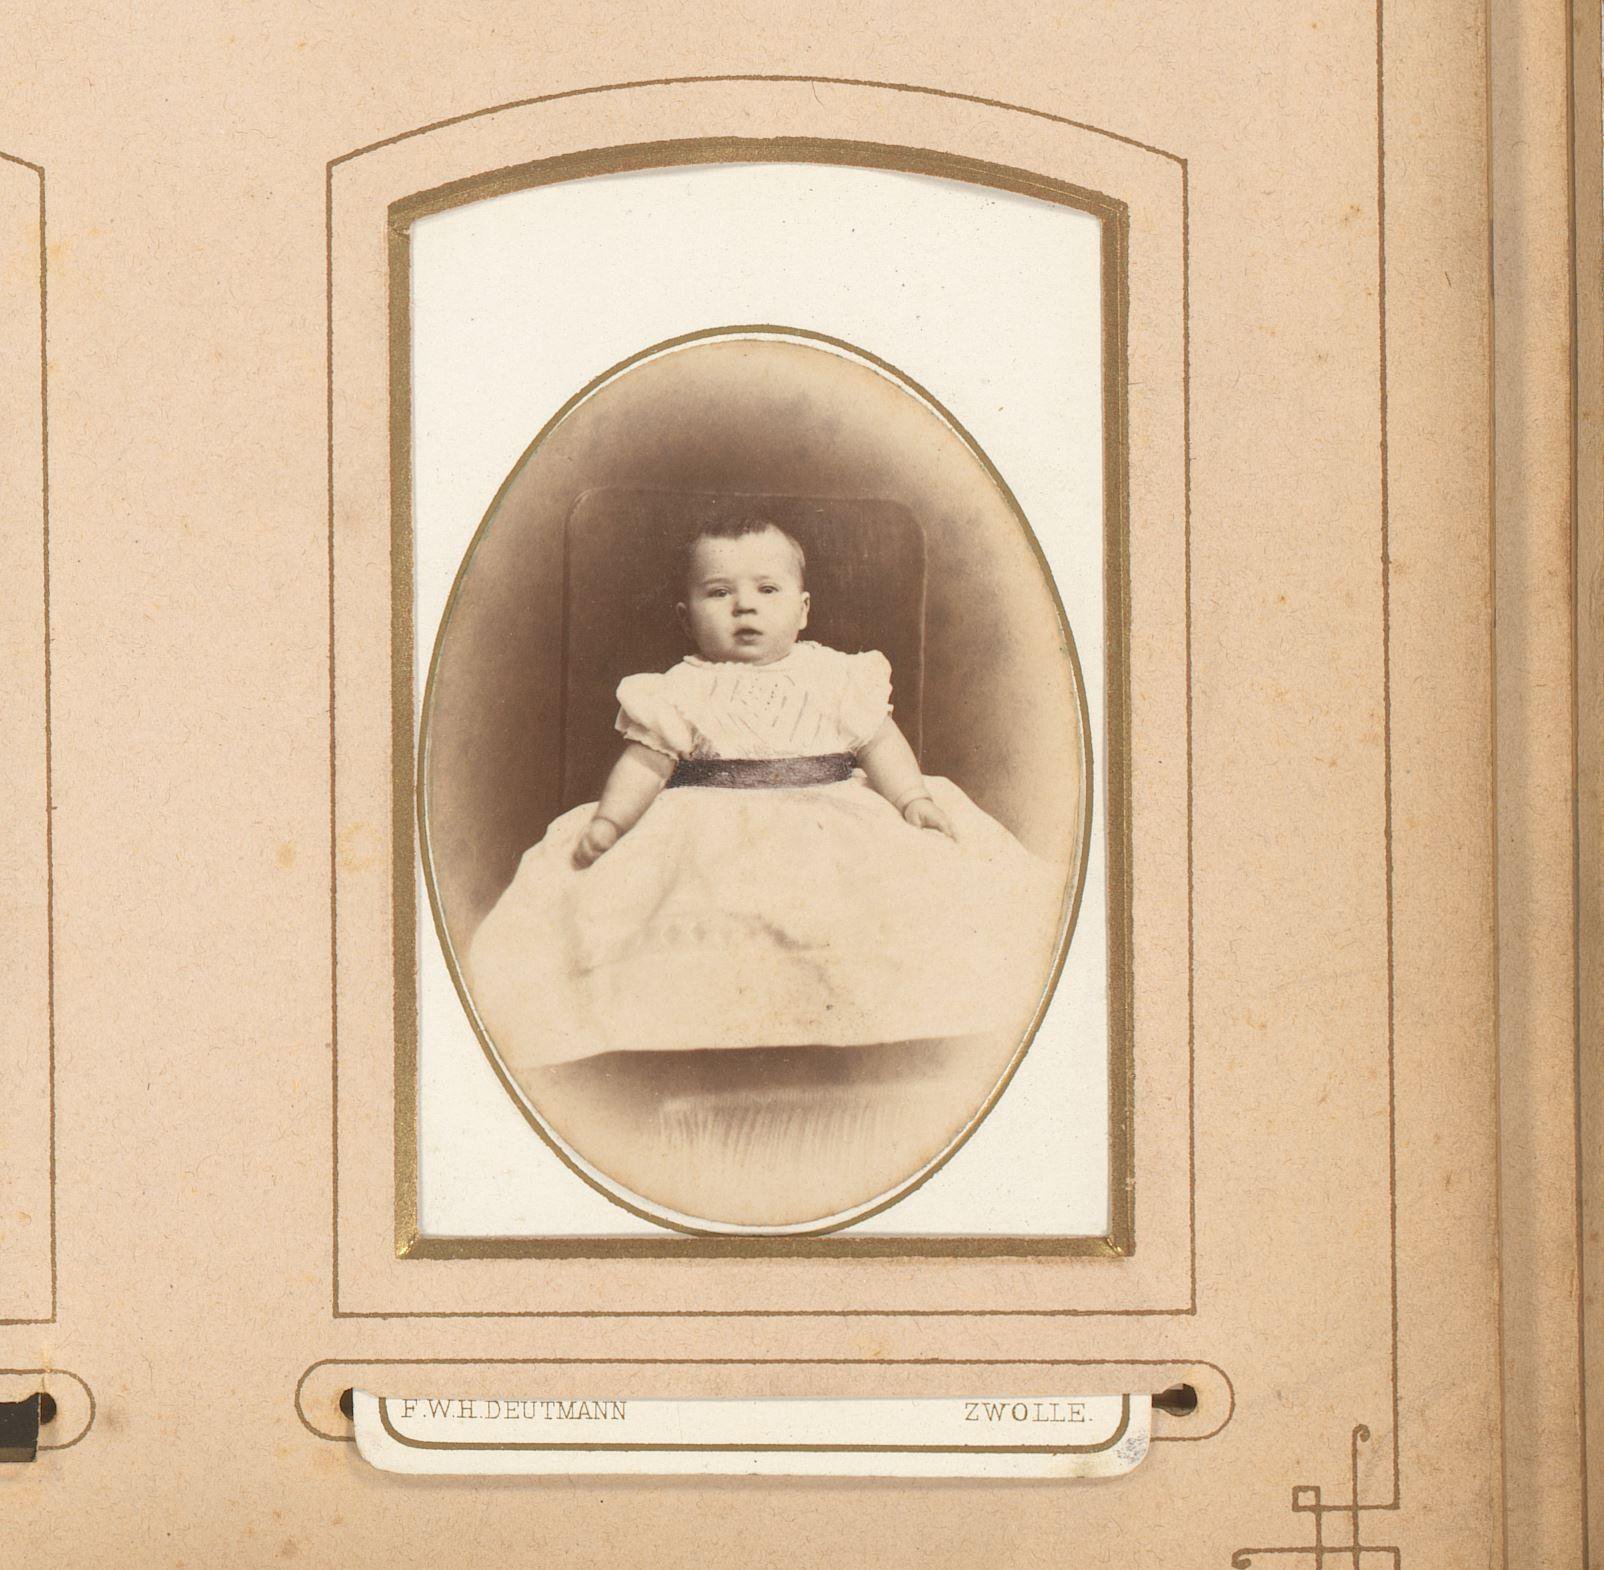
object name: photograph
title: Portret van een baby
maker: franz wilhelm heinrich deutmann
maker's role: fotograaf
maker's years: 1840-1906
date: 1880-1905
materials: cardboard, photographic support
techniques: albumen print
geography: zwolle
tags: infant, baby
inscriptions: inscription: ‘F.W.H. Deutmann/ Zwolle’